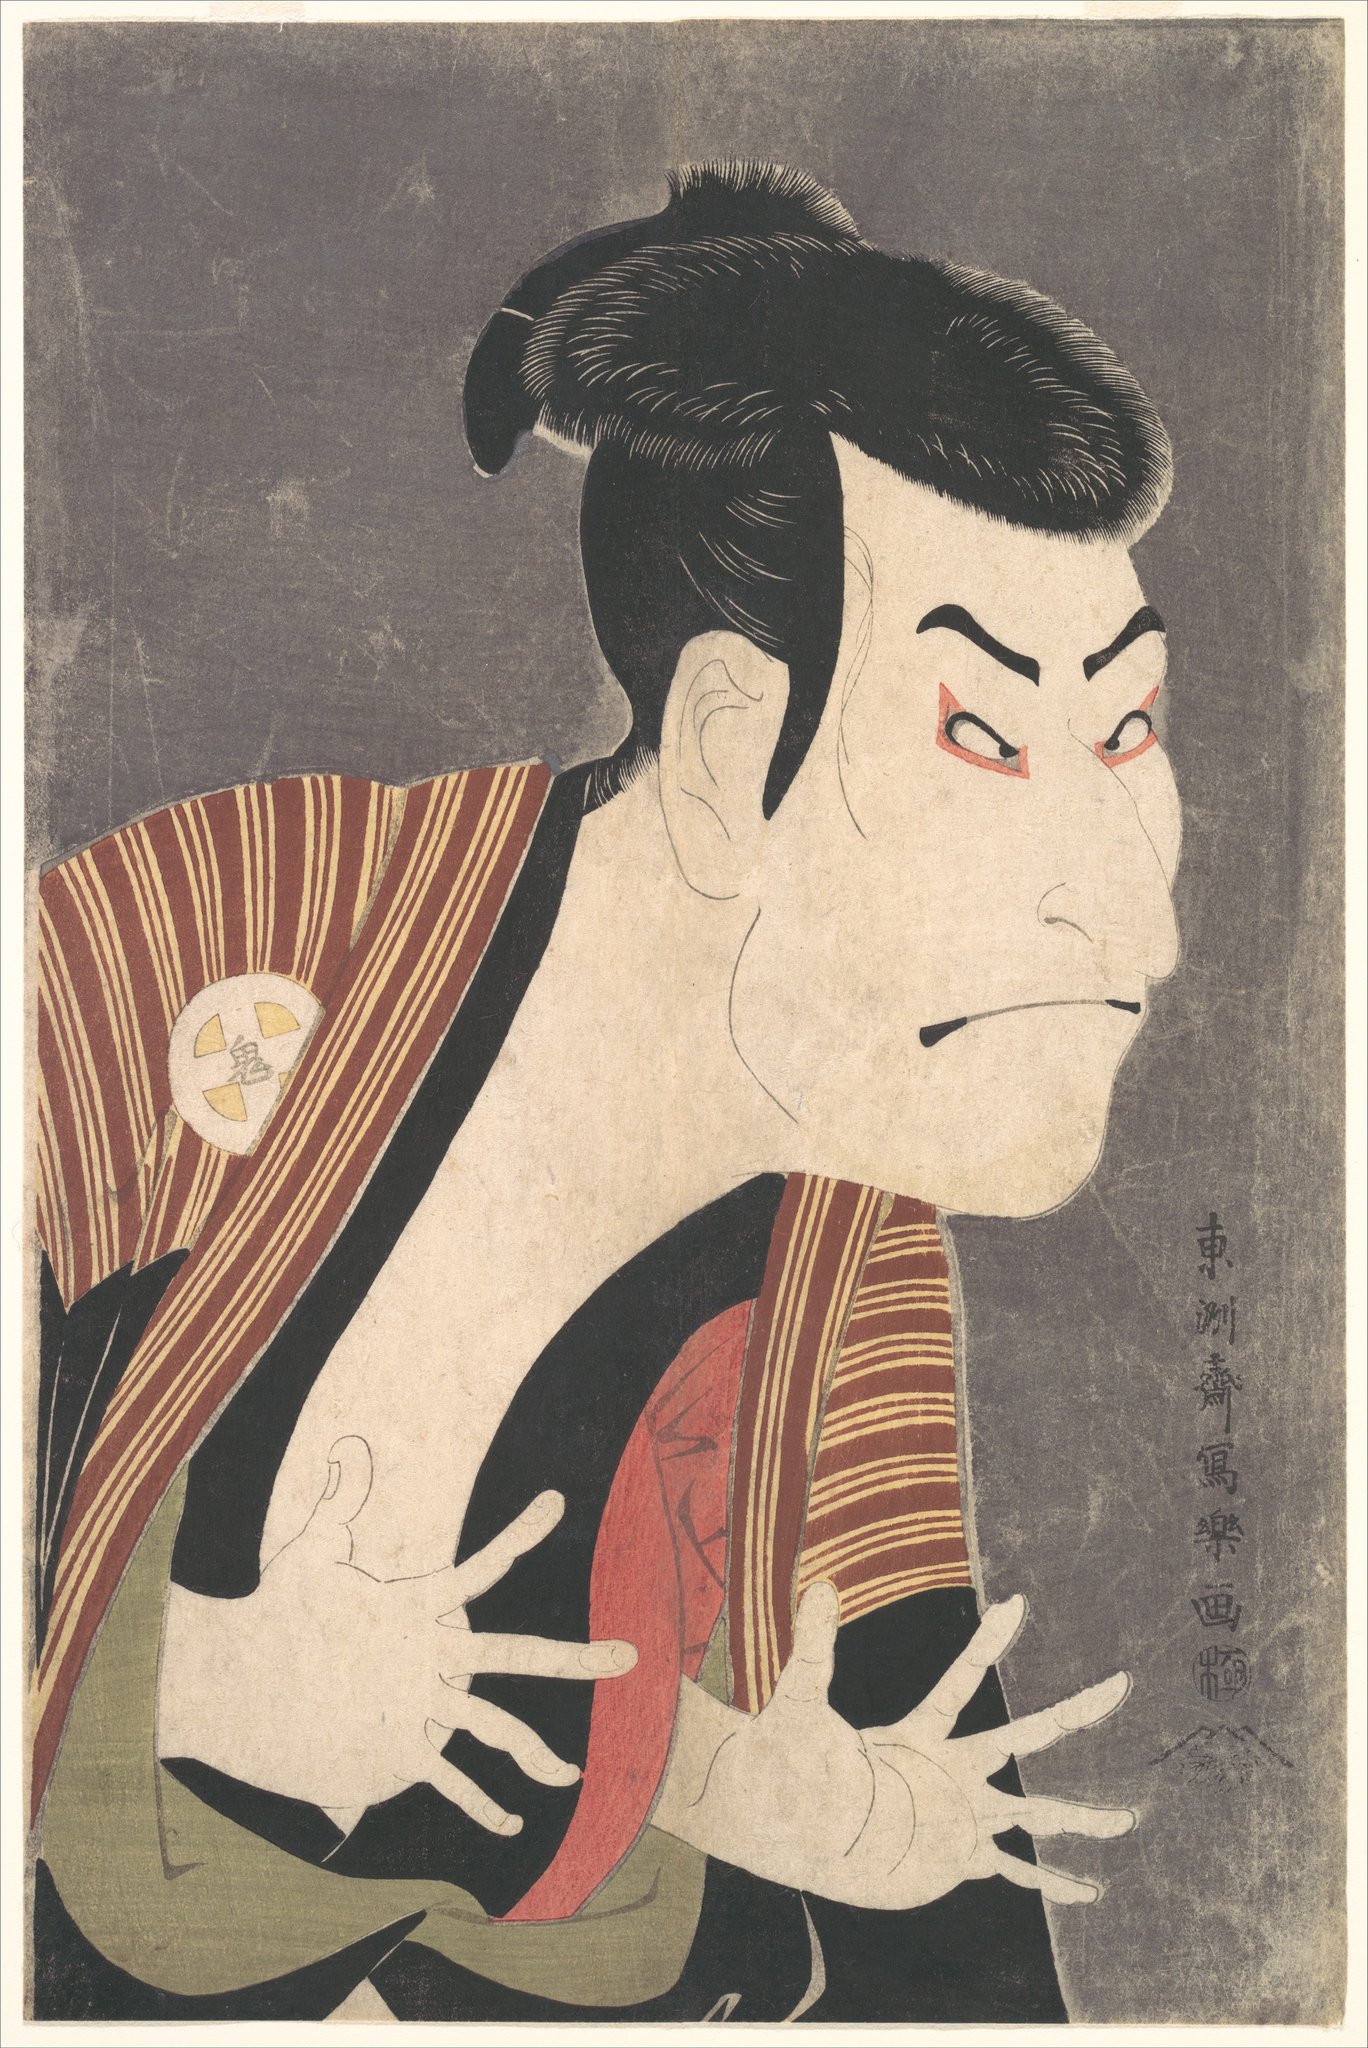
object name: print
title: Kabuki Actor Ōtani Oniji III as Yakko Edobei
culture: japanese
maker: tōshūsai sharaku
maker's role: artist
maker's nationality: japanese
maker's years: 1794-1795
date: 1794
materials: ink, mica, paper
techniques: woodblock print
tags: men,actors